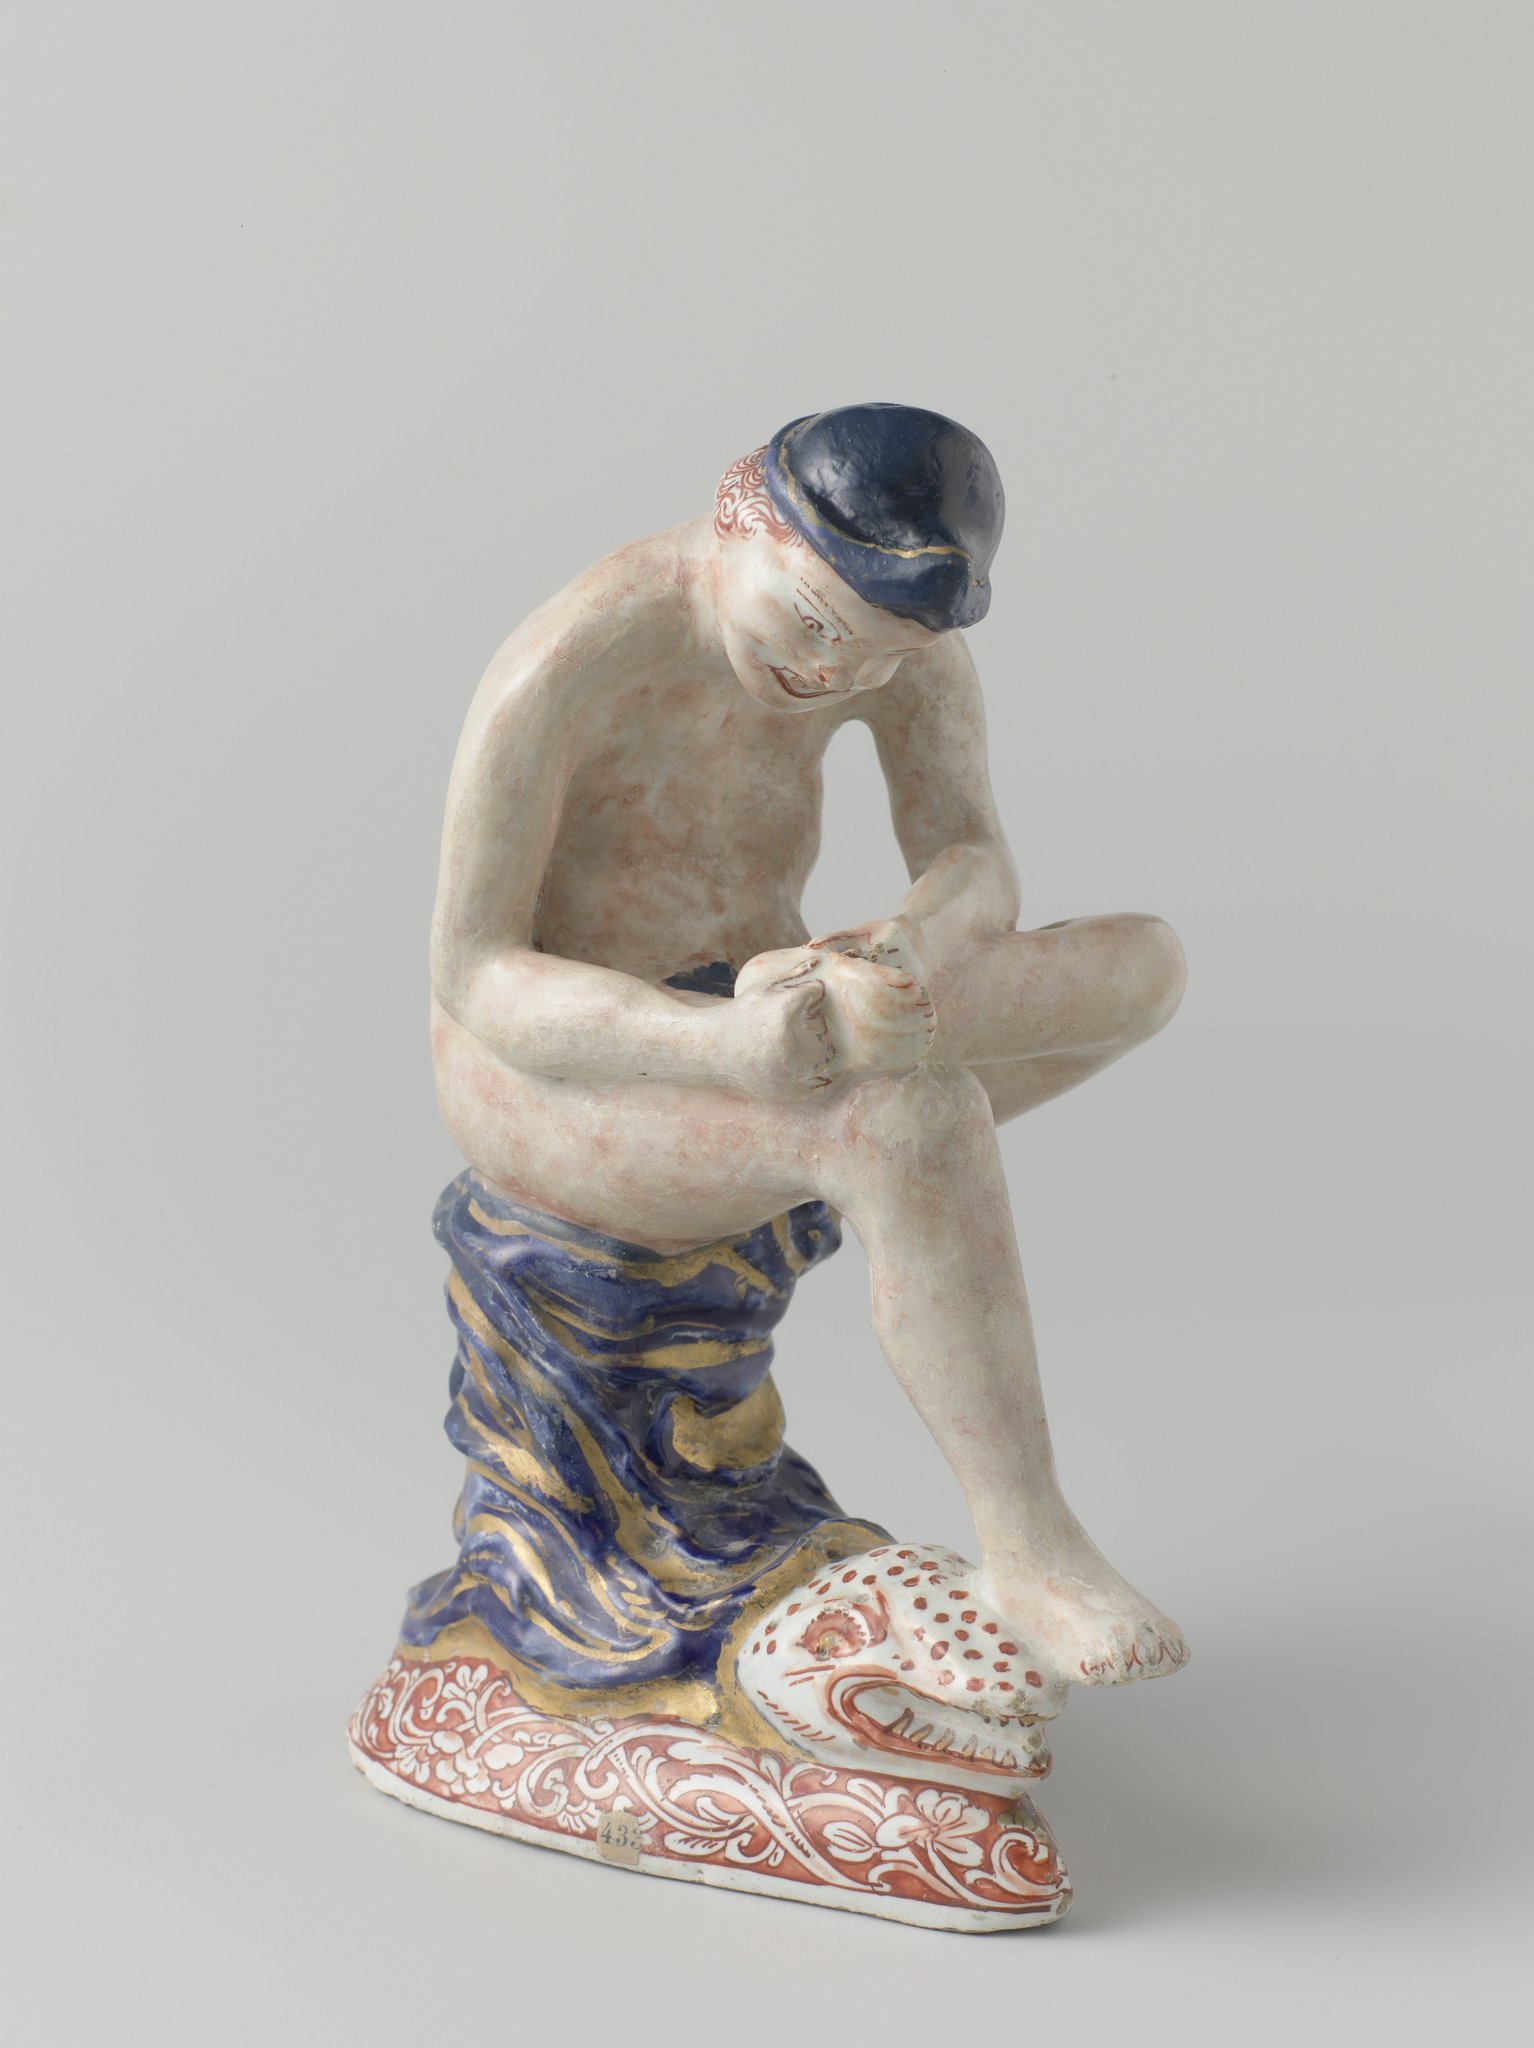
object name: decoratief object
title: Doornuittrekker van faïence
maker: Anonymous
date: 1720-1740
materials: faience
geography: delft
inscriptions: collector's mark: ‘433’, collector's mark: ‘collection J.F. Loudon’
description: Mannenfiguur van faïence. Voorstellende een doornuittrekker.